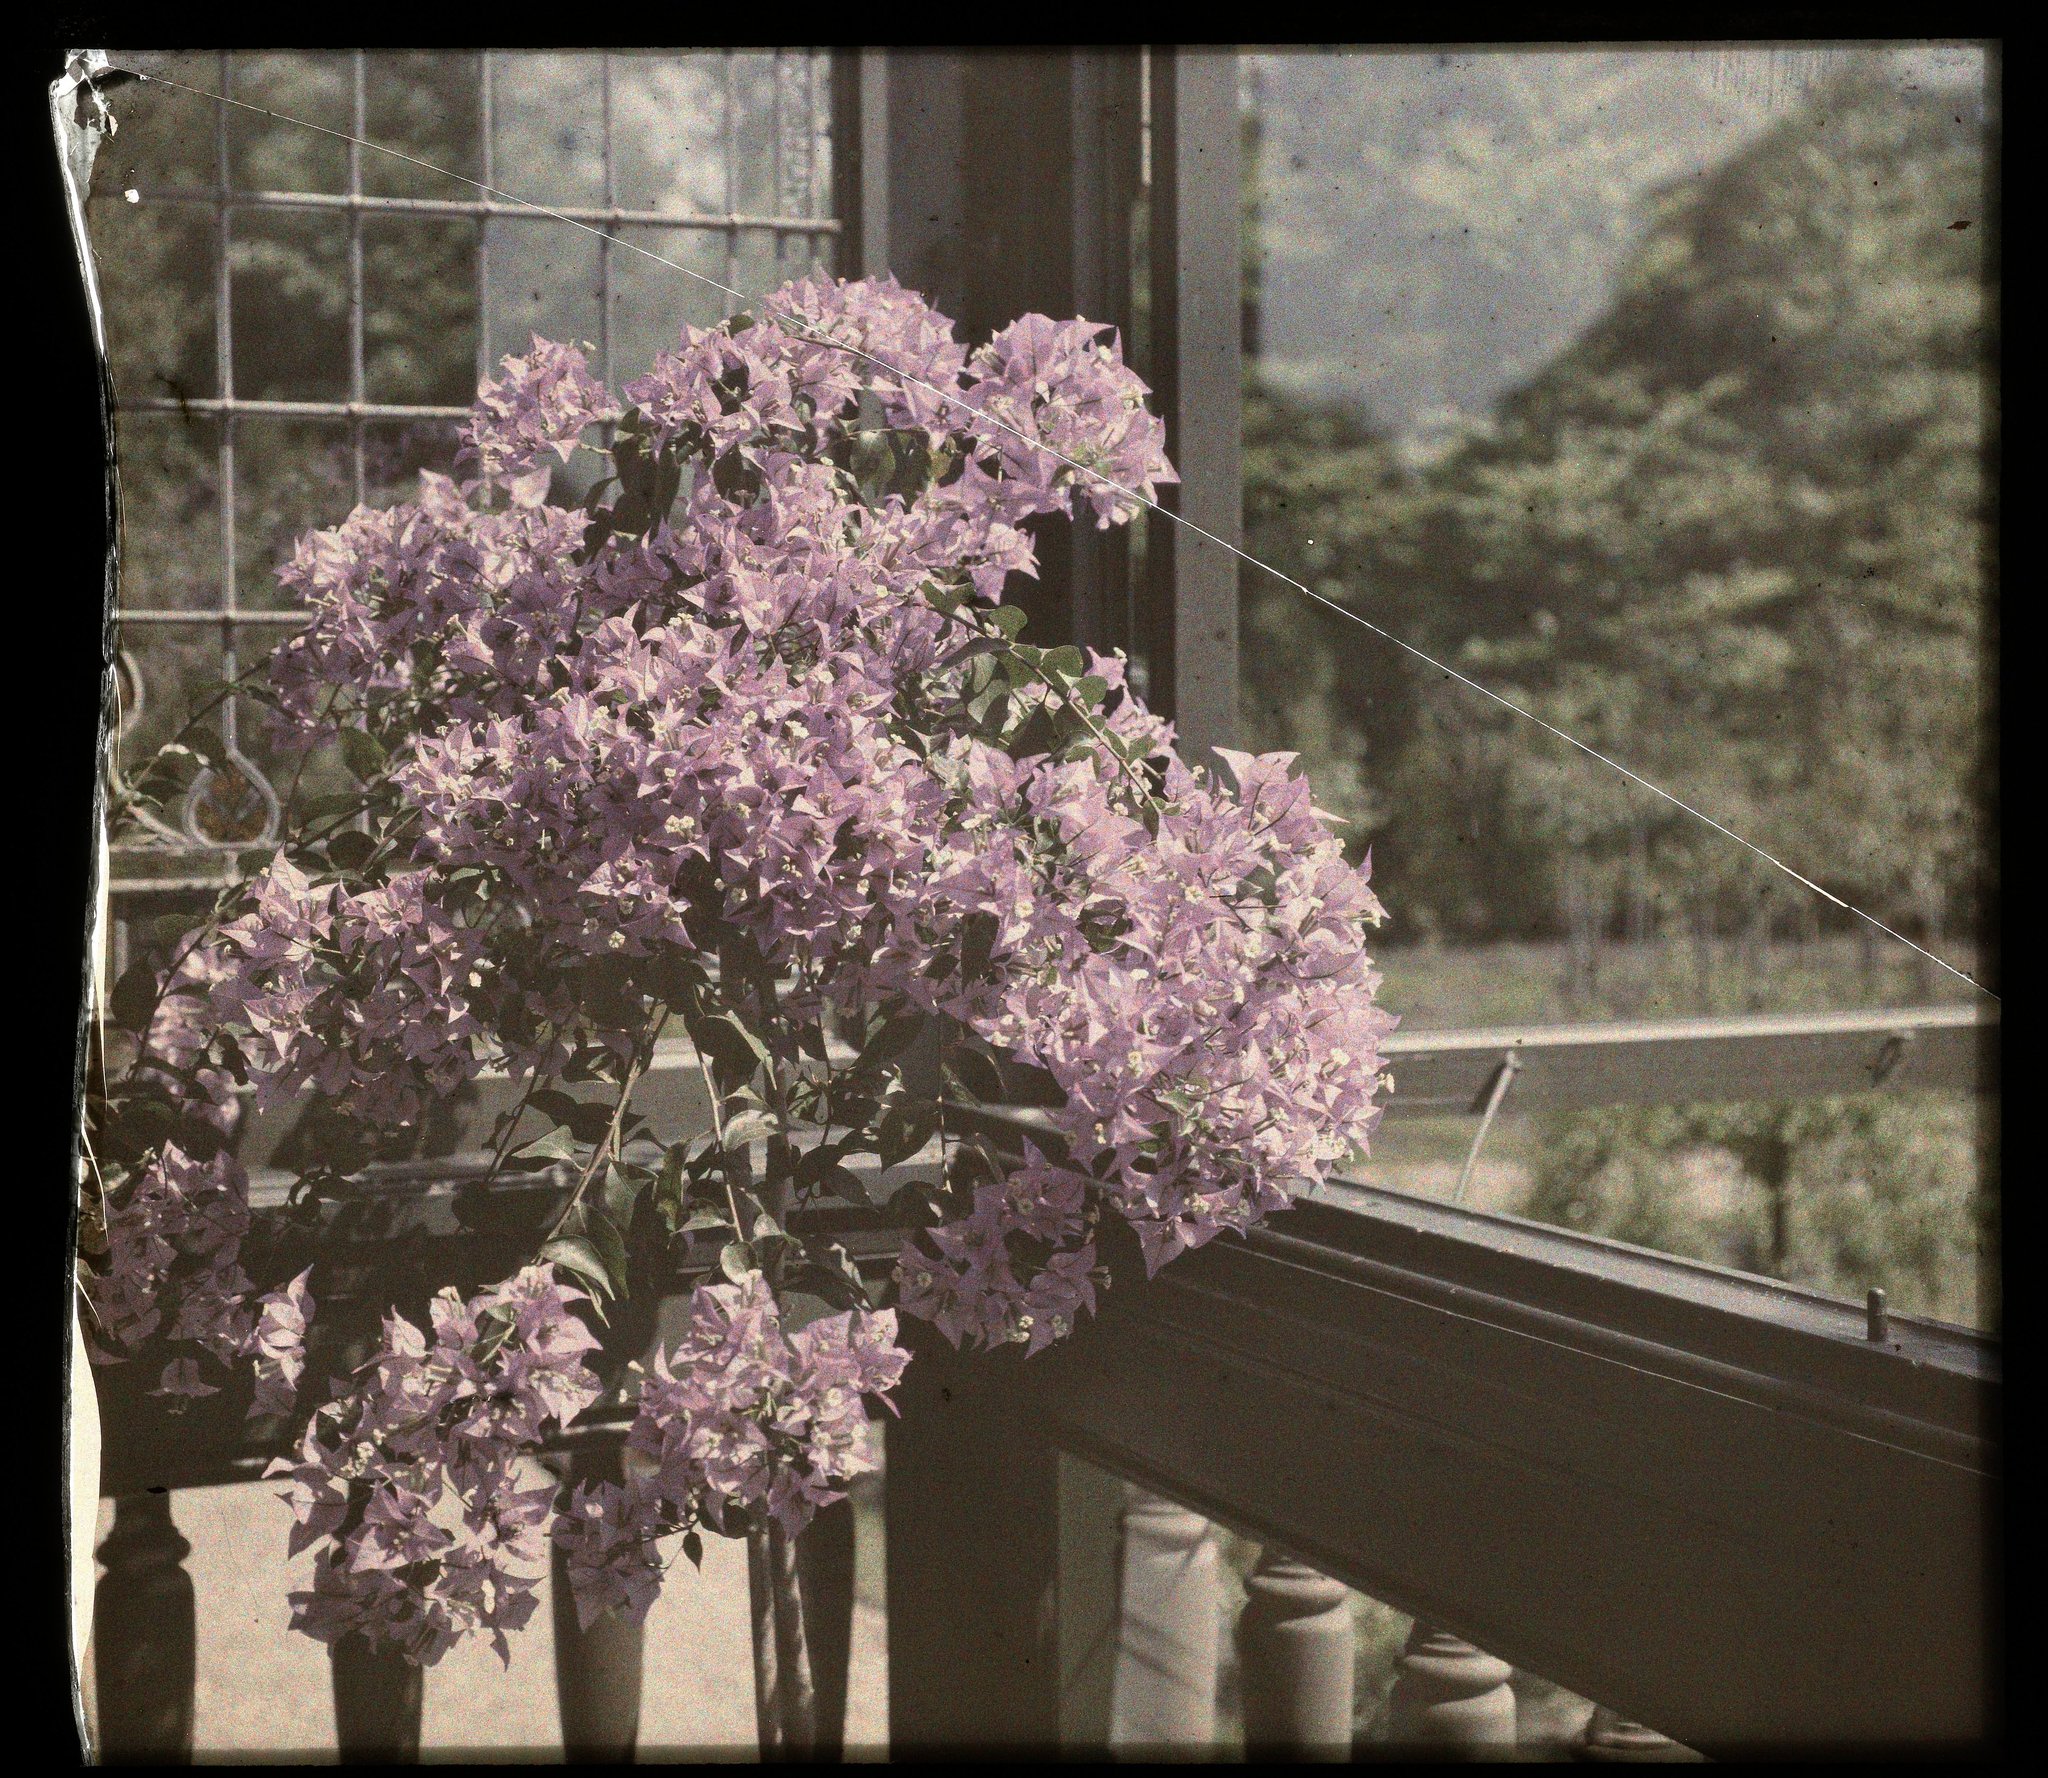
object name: glasdia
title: Plant op een balkon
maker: adolphe burdet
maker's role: fotograaf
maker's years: 1860-1940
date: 1907-1930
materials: glass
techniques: autochrome process, slide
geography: netherlands